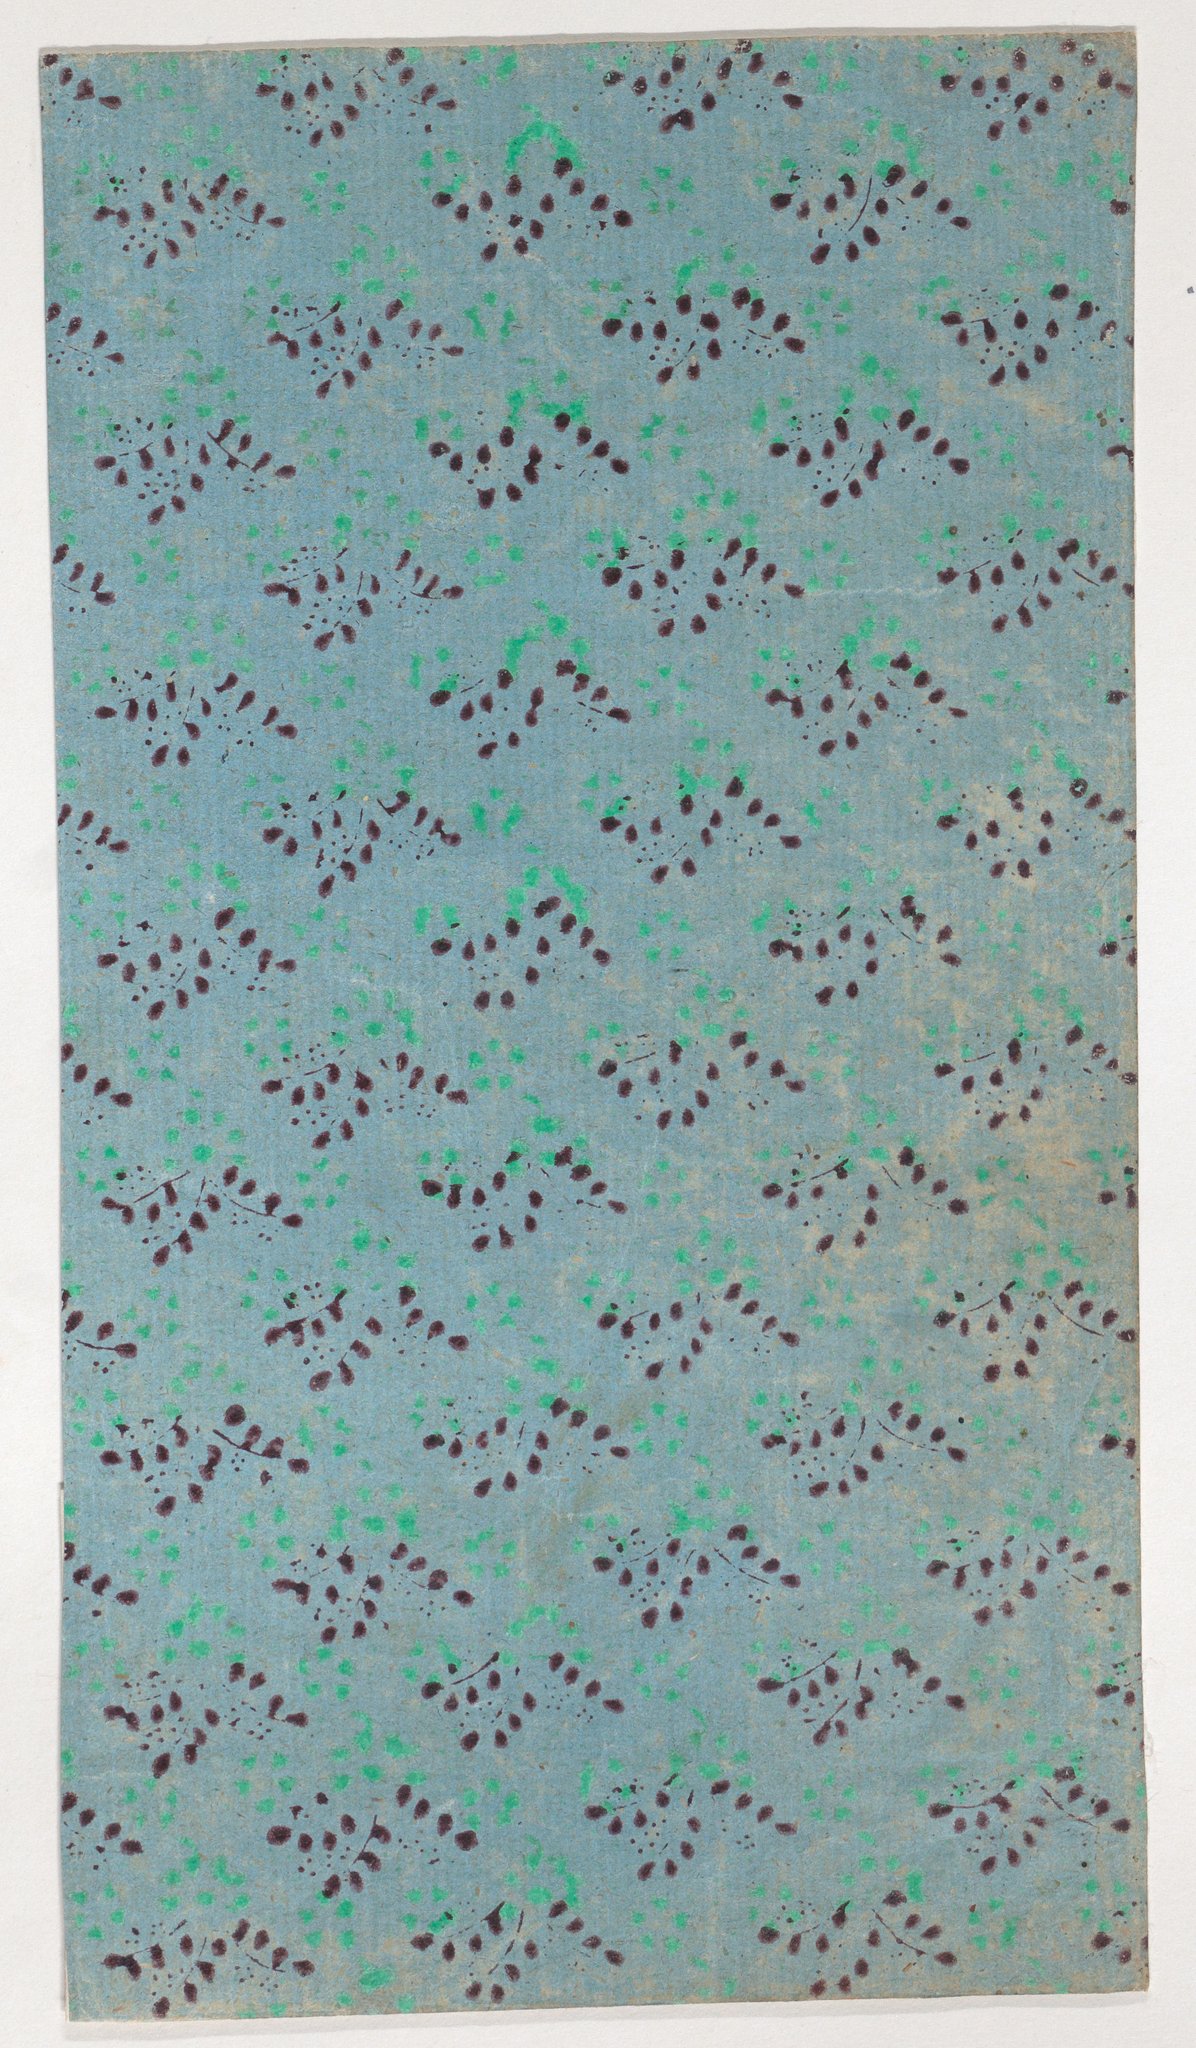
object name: print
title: Sheet with overall pattern of green and brown leaves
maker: Anonymous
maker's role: artist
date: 1801-1900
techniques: relief print